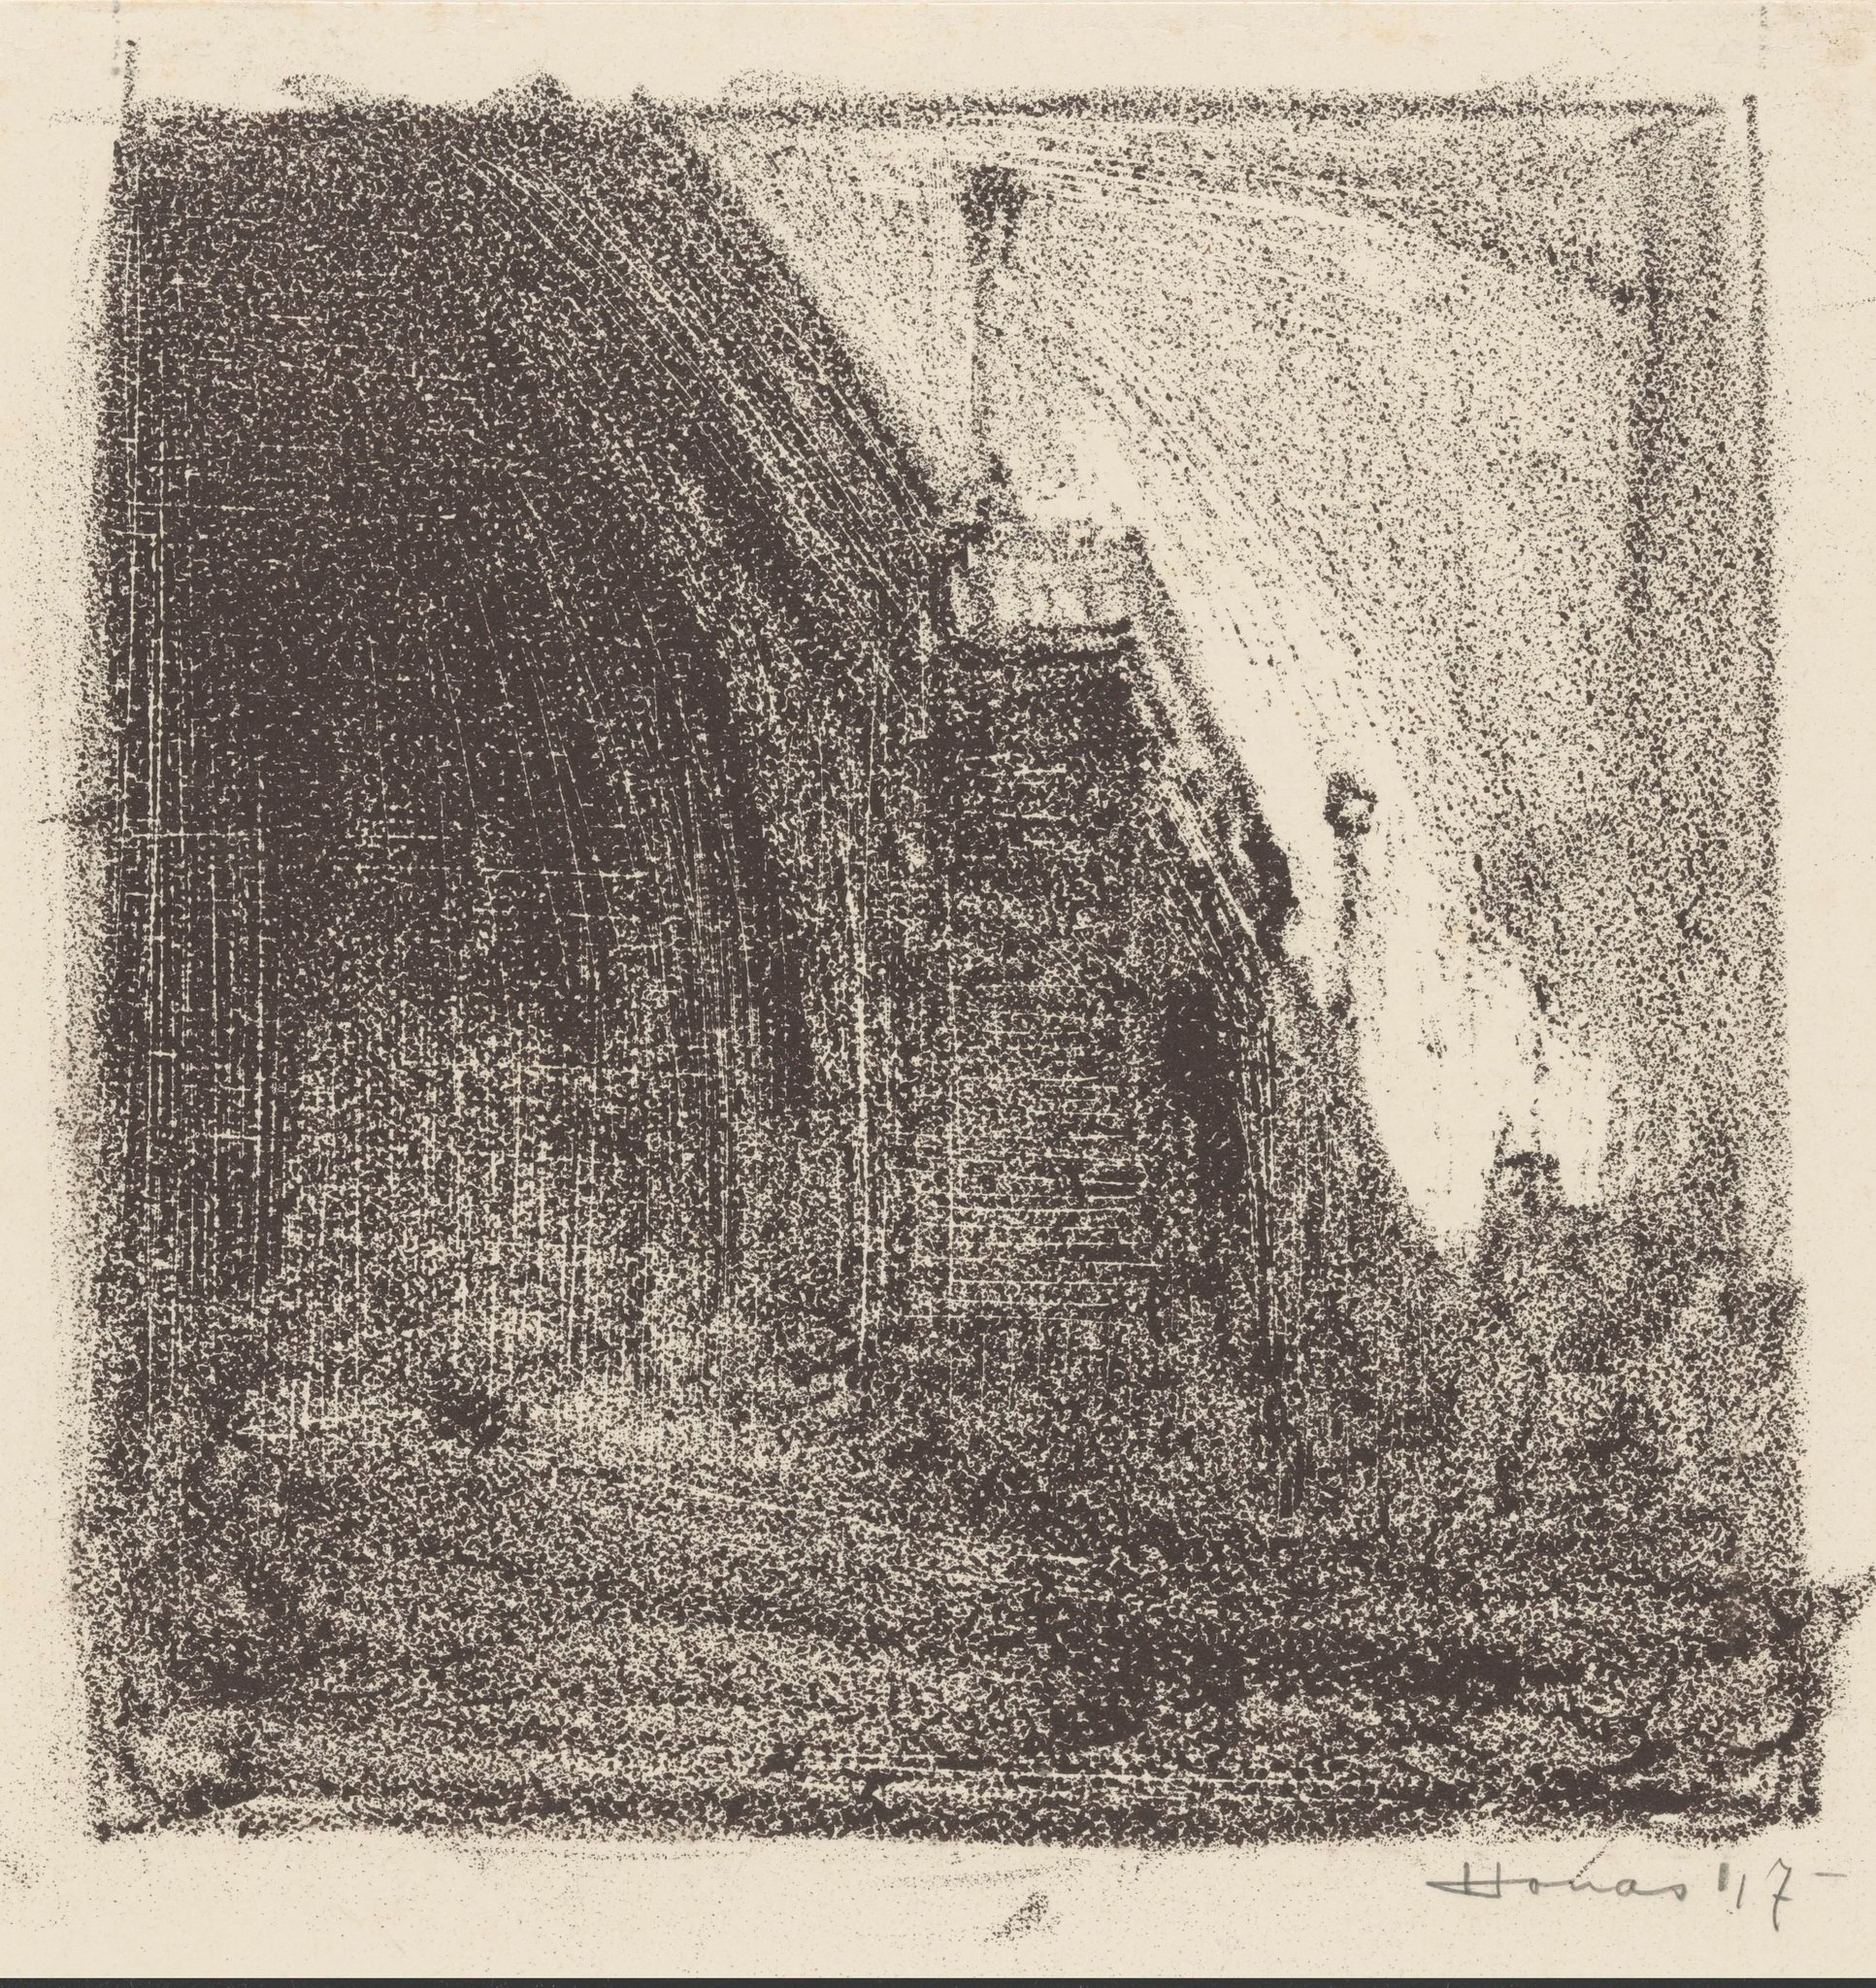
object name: print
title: Boogbrug, mogelijk de Sint Servaasbrug over de Maas in Maastricht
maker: henri jonas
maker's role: draughtsman, print maker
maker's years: 1878-1944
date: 1917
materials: paper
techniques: lithograph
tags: bridge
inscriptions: collector's mark: Lugt 2228